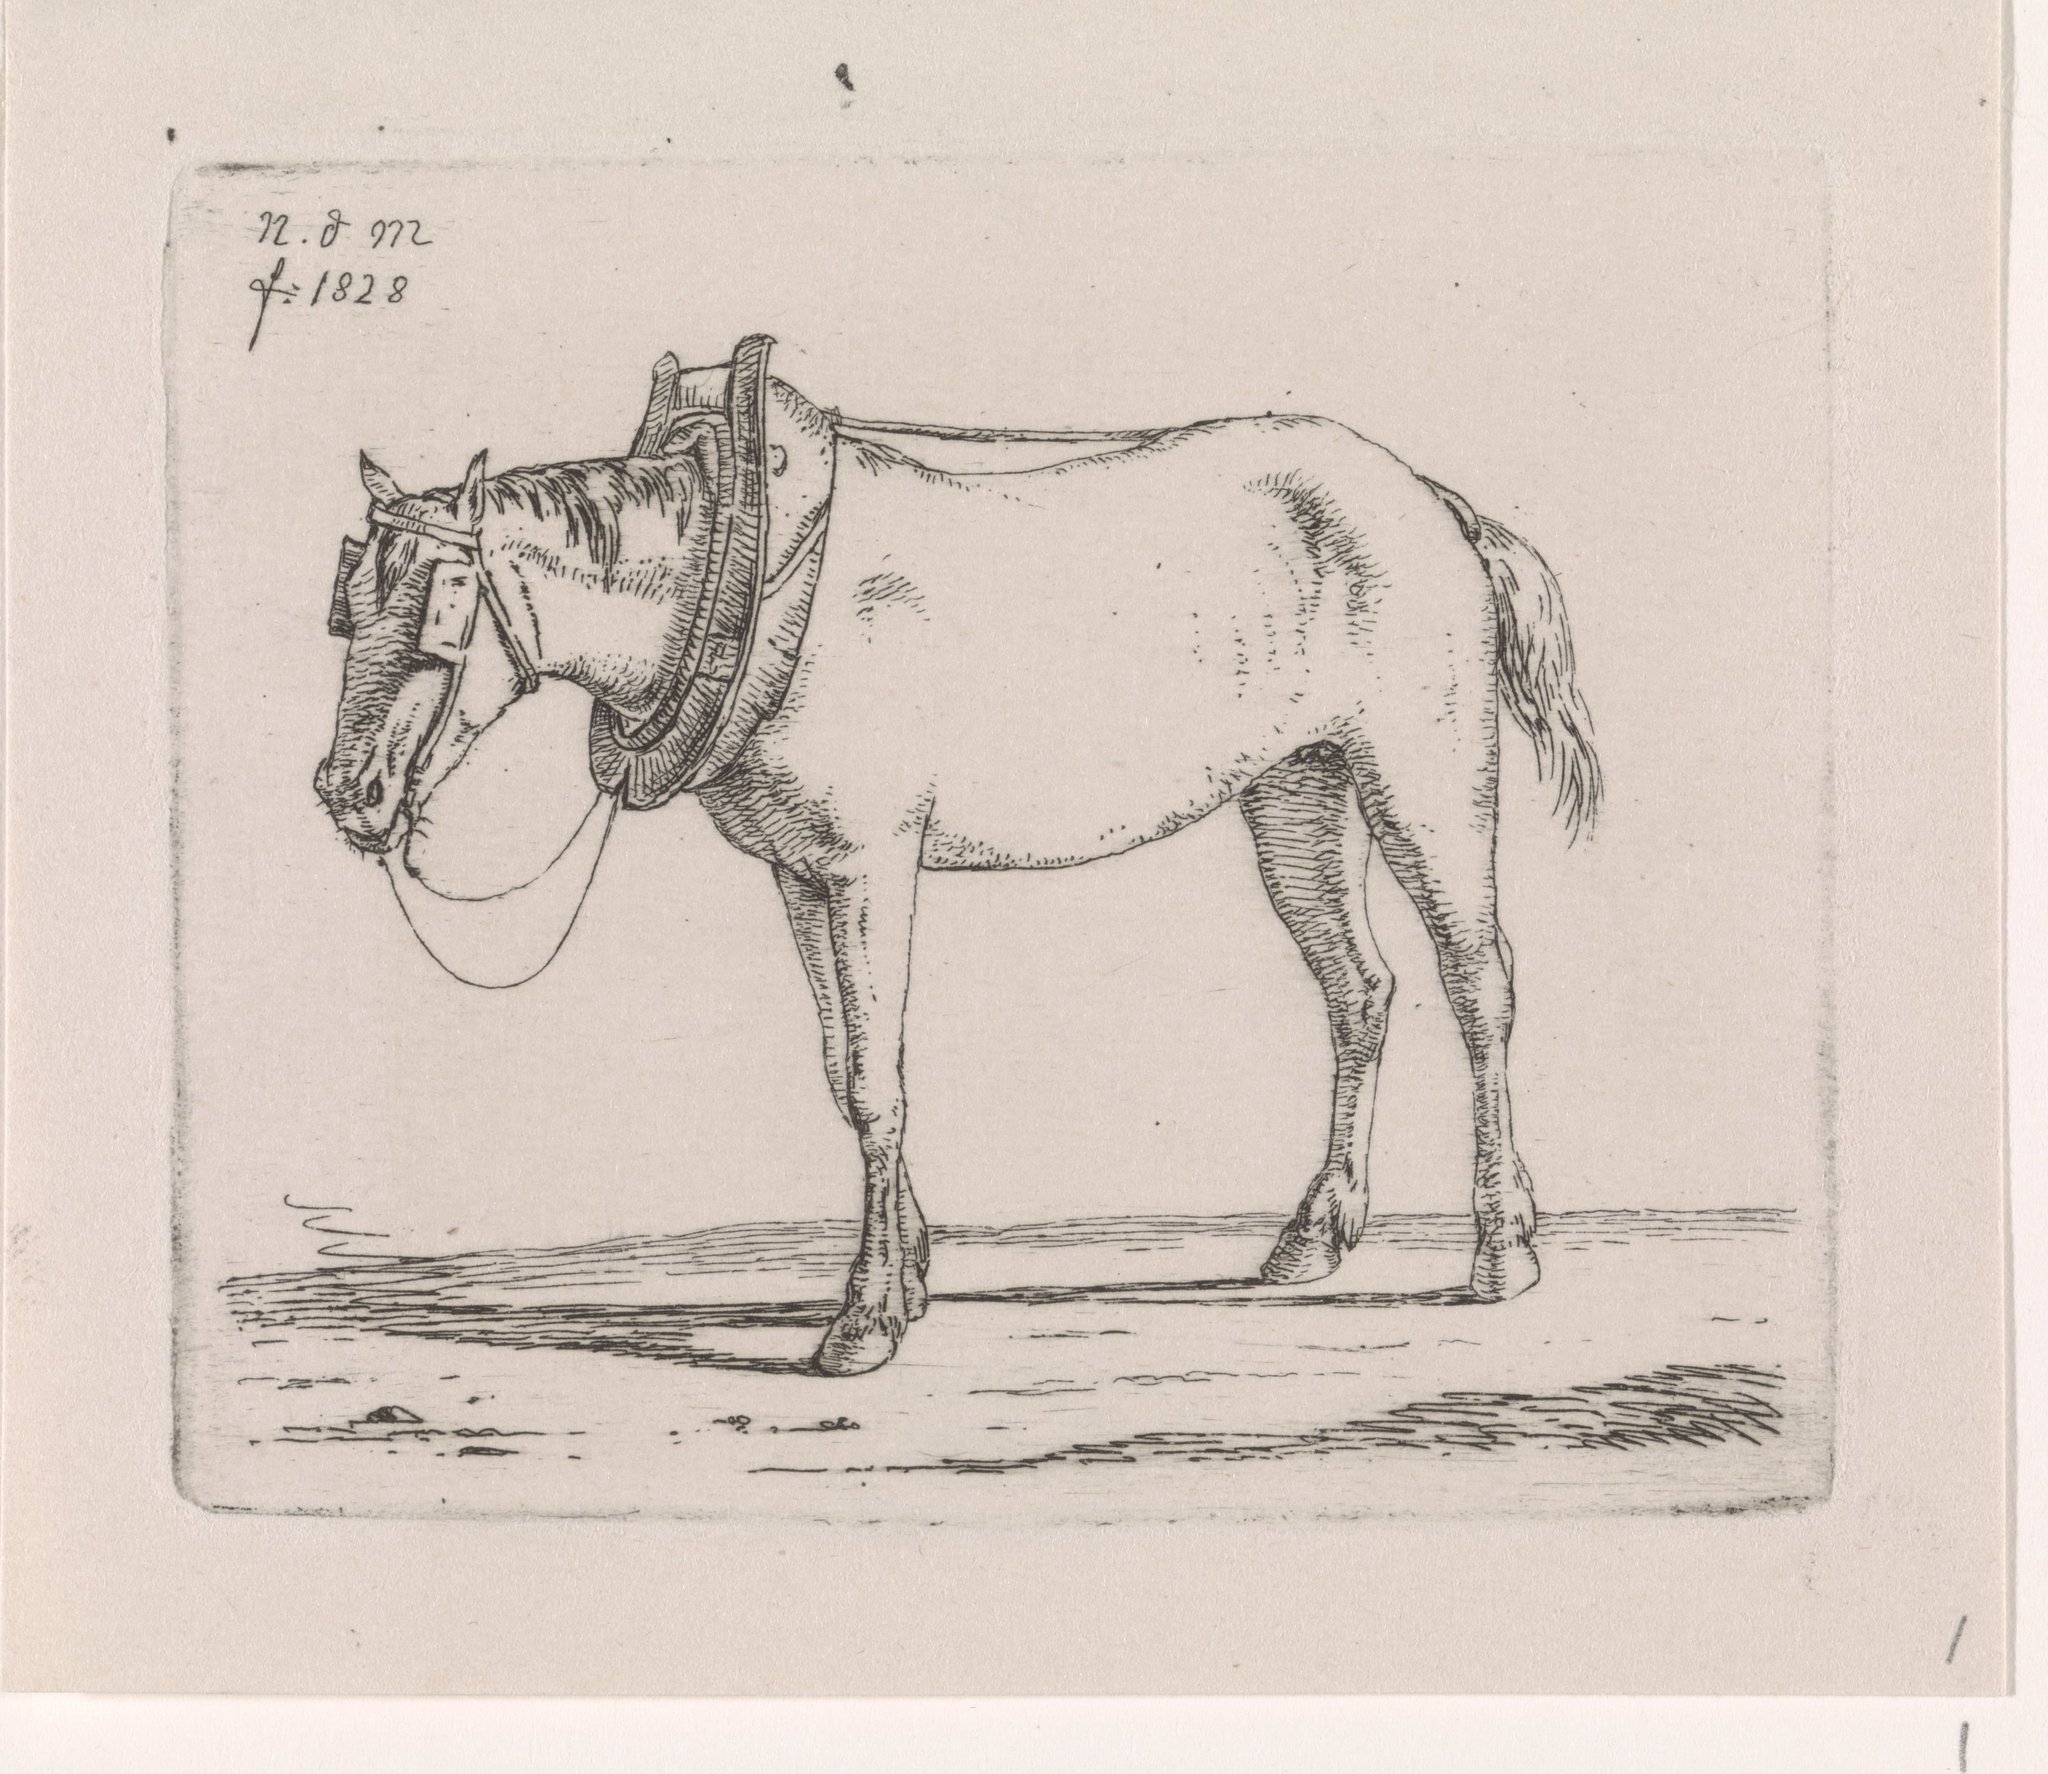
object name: print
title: Trekpaard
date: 1828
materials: paper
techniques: etching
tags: horse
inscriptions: collector's mark: Lugt 2228